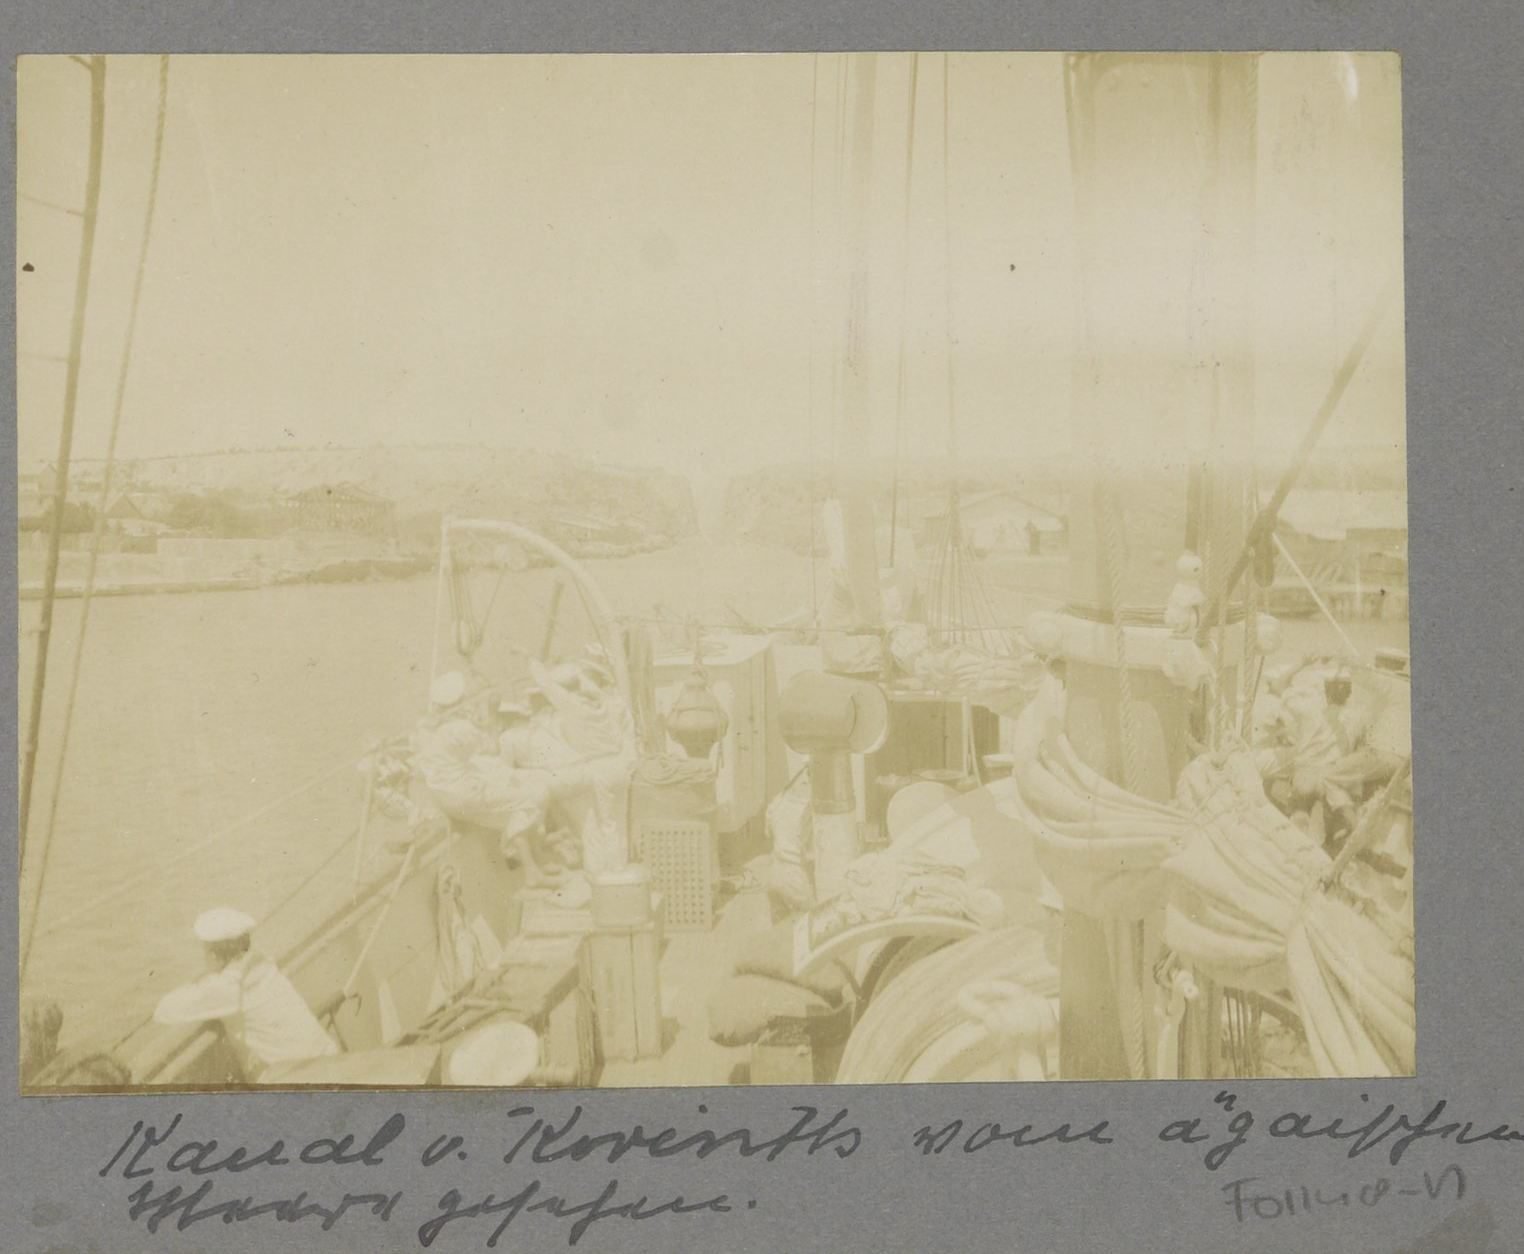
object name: photograph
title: Bemanning van de S.M.S. Loreley aan dek, op de achtergrond vermoedelijk het Kanaal van Korinthe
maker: Anonymous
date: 1905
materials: paper, photographic support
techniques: albumen print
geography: greece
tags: parts of ship's exterior: deck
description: Onderdeel van Reisalbum met foto's van bezienswaardigheden in Griekenland en Egypte.